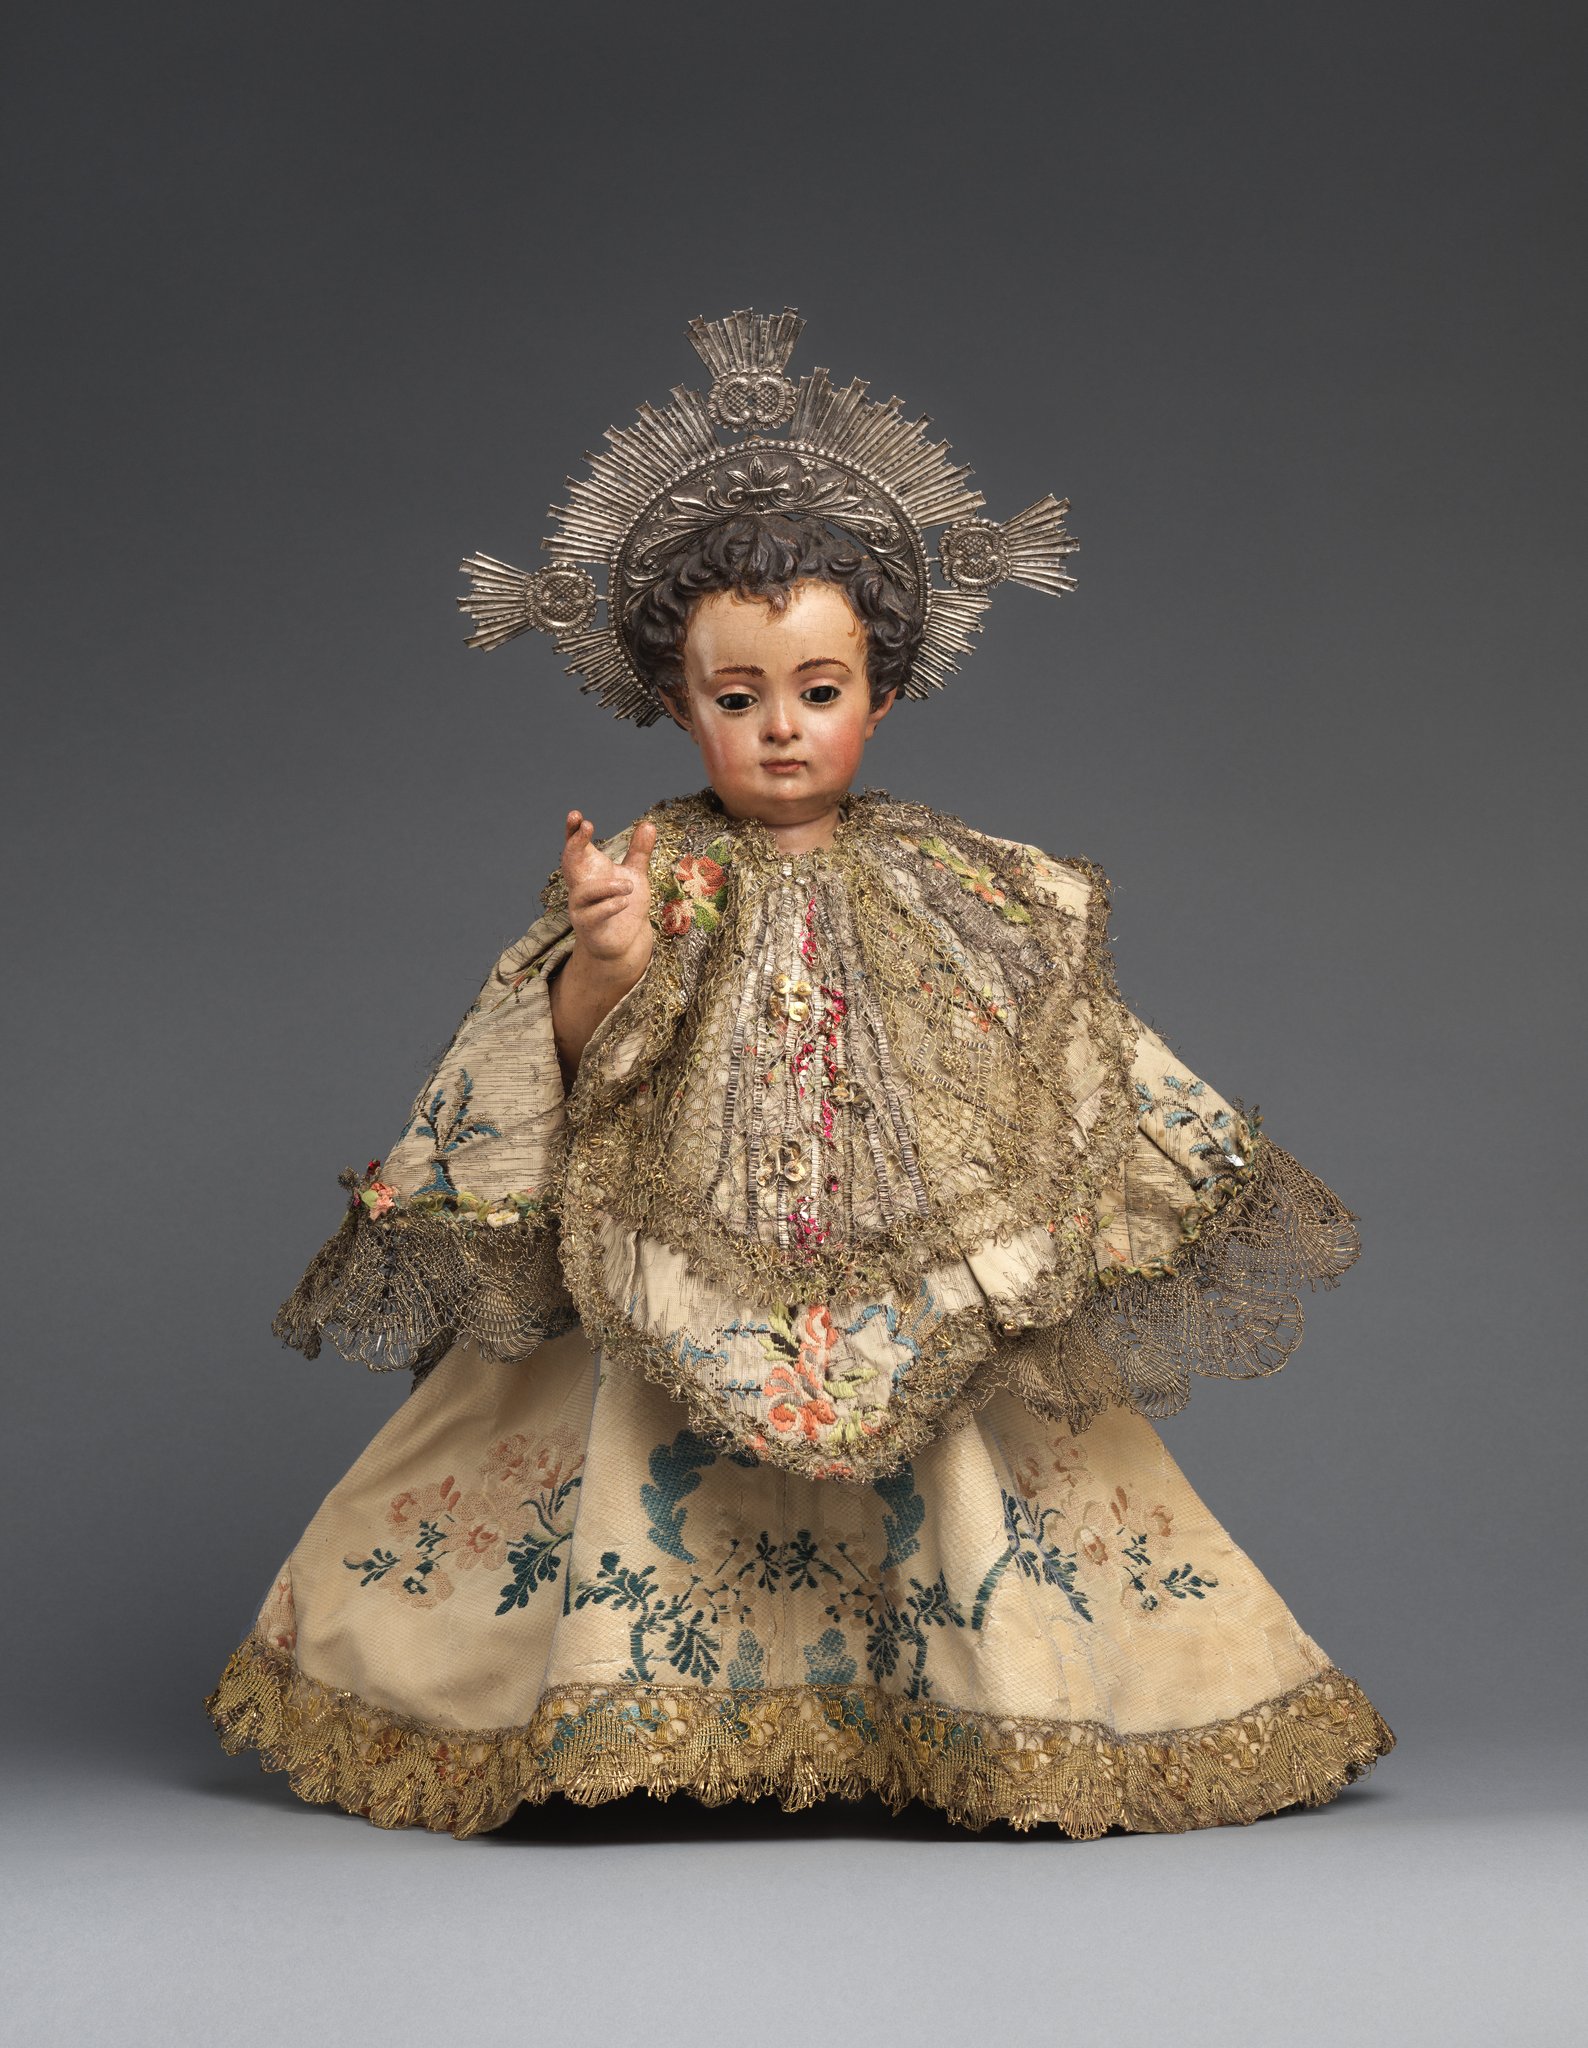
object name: capelet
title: Capelet for a statuette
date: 1601-1800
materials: glass, lace, lead, silk, silver, silver gilt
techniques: polychrome